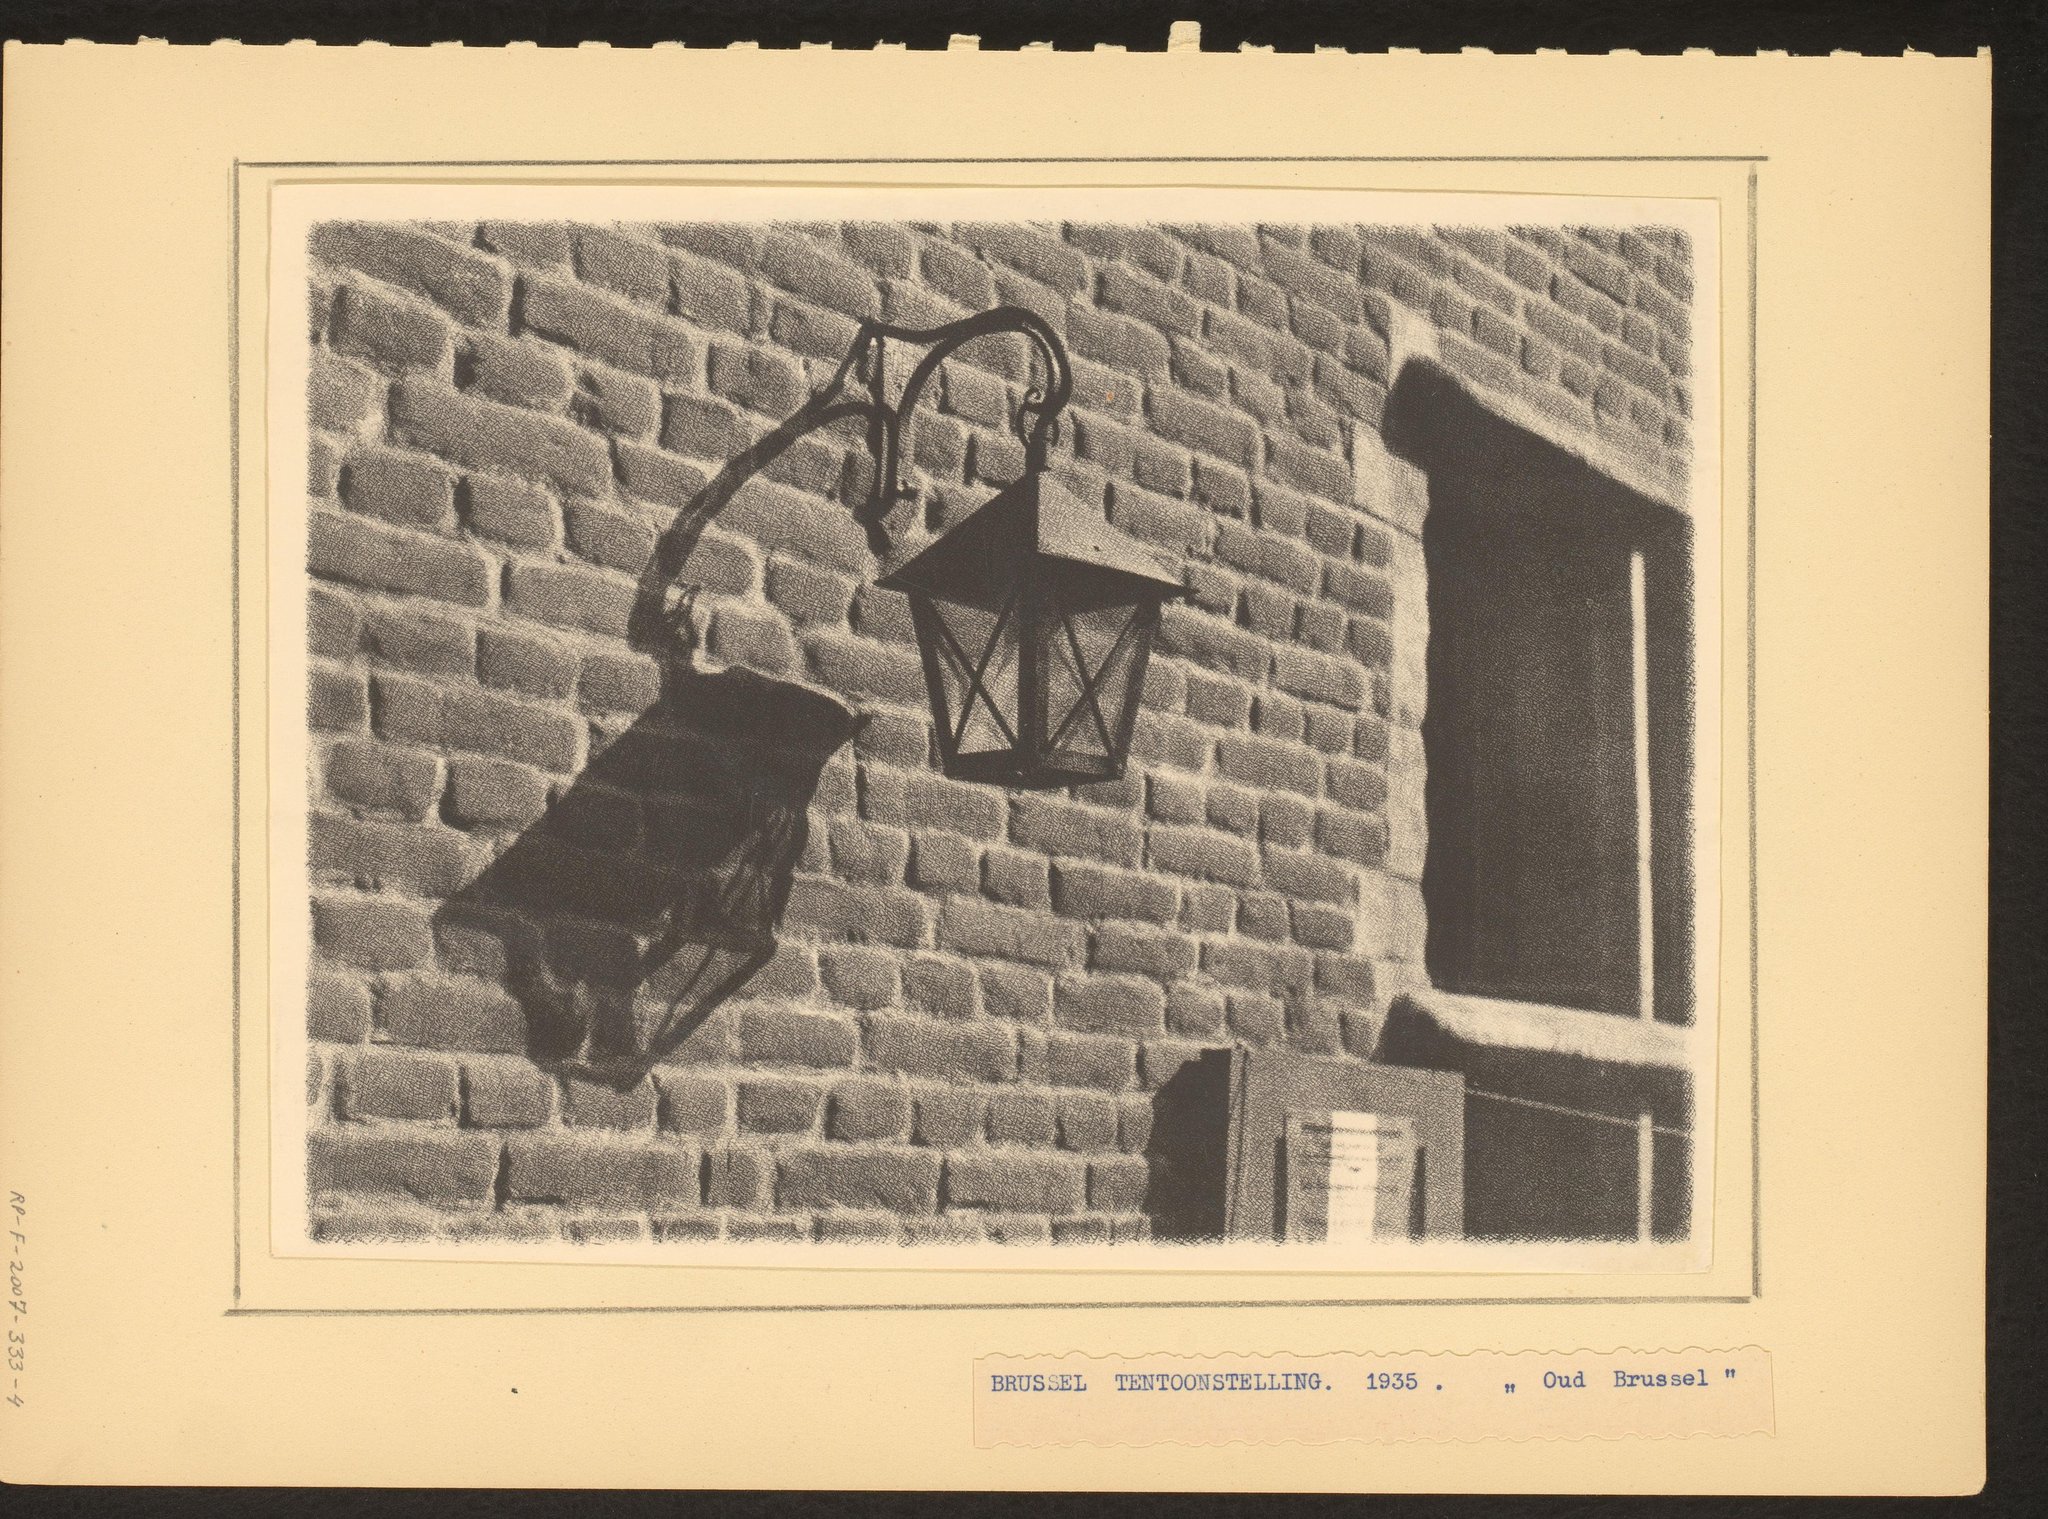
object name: photograph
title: Brussel Tentoonstelling. 1935. "Oud Brussel"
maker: gerrit elink schuurman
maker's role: fotograaf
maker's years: 1876-1953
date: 1935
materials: paper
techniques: gelatin silver print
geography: brussels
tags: world fair, world exhibition, lantern, brussels